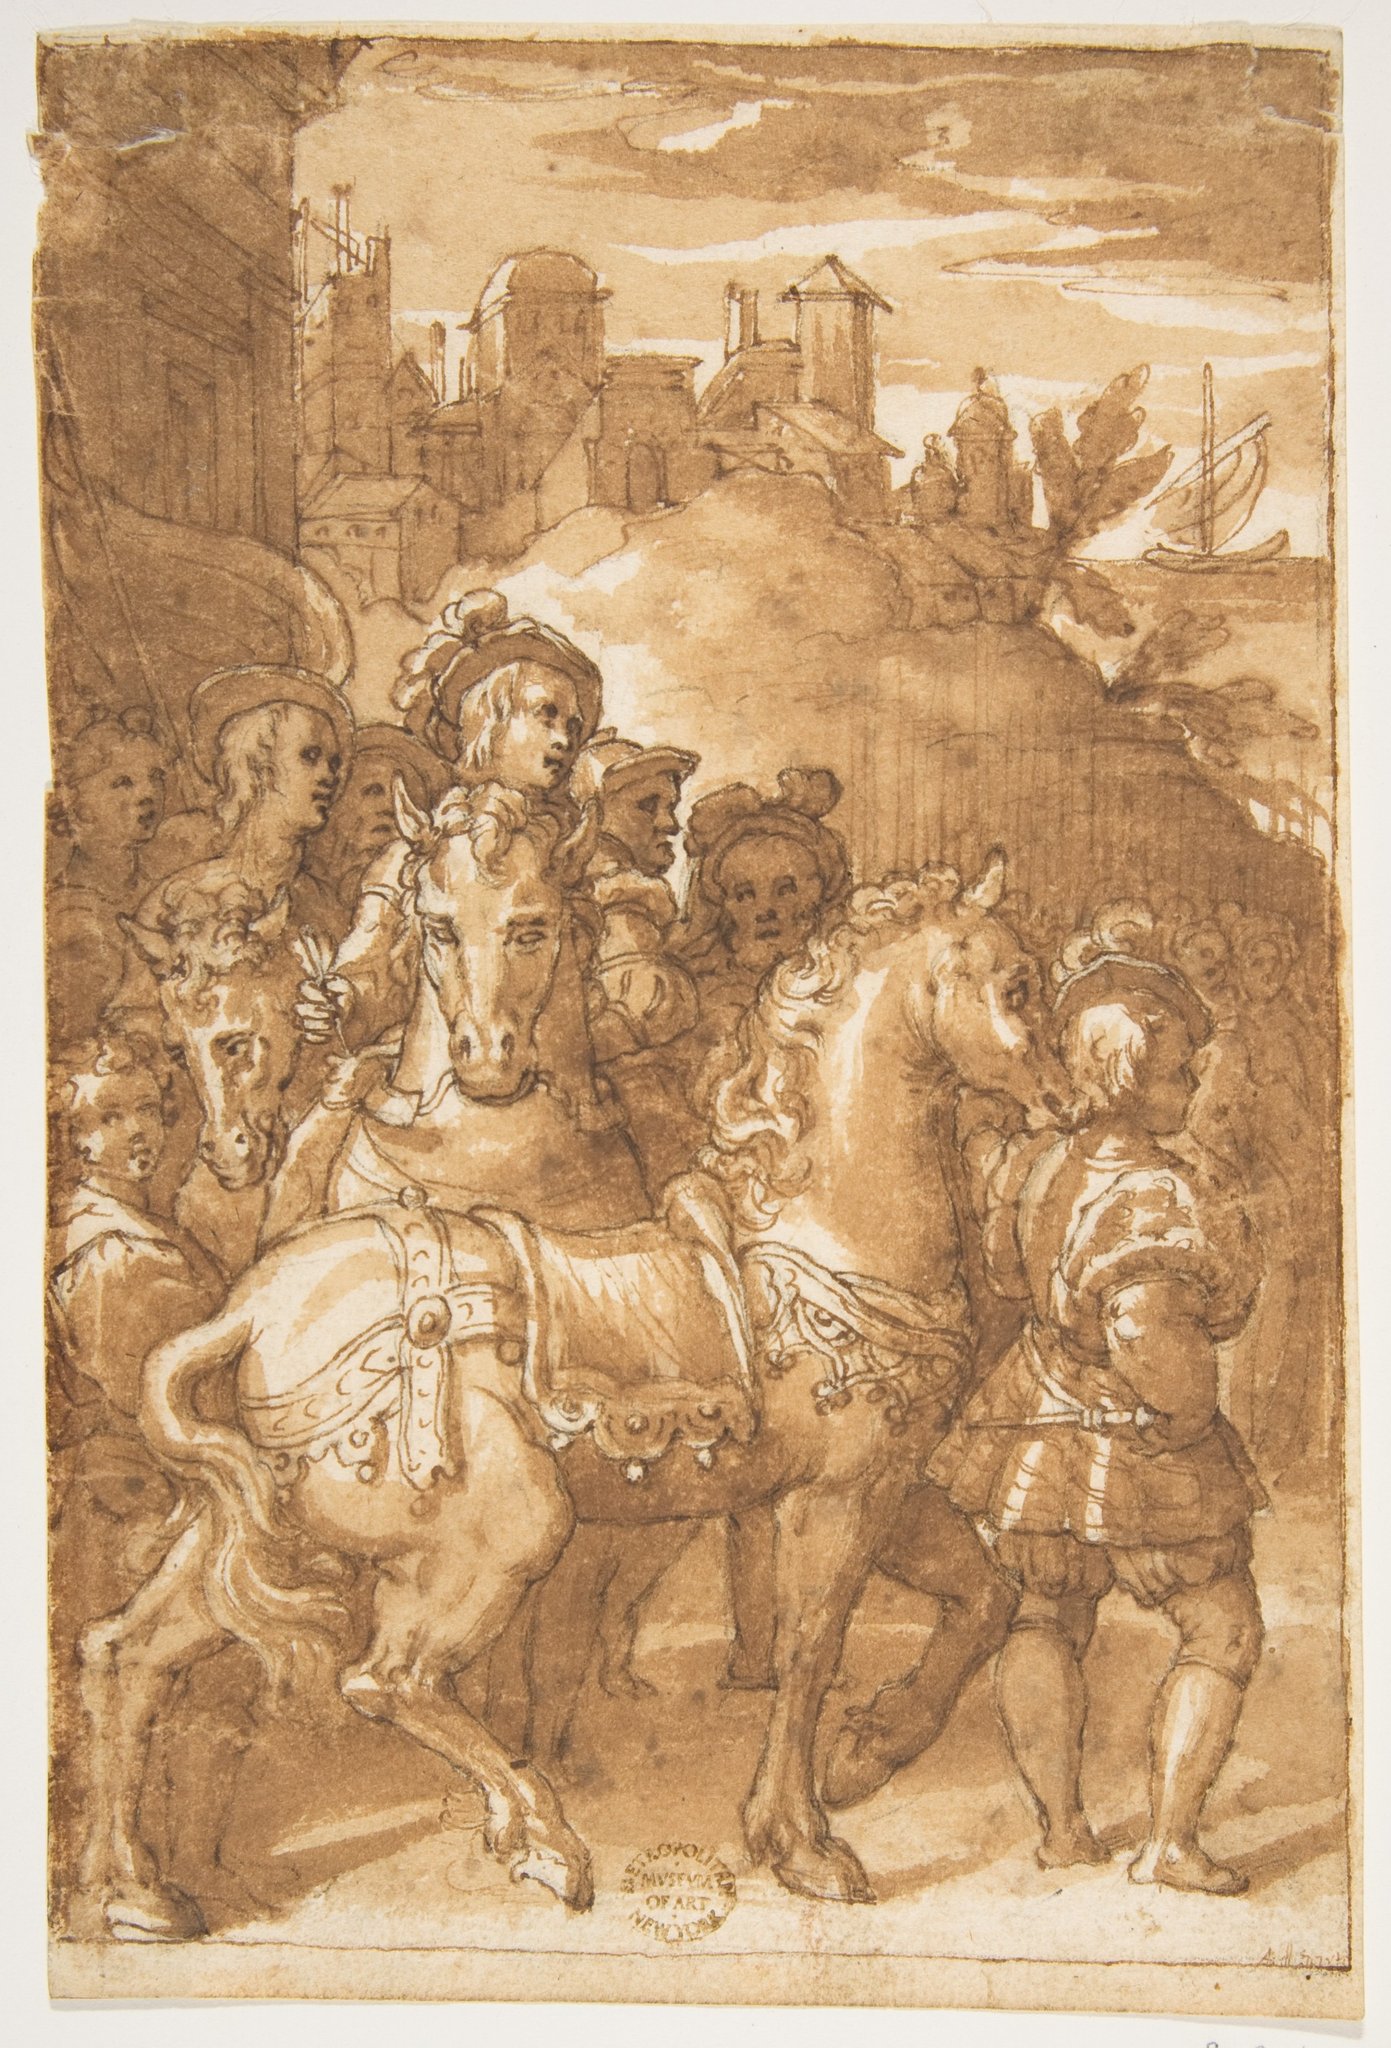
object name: drawing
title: Study for the Armistice between King Francis I of France and Emperor Charles V, fresco in the Palazzo Farnese, Caprarola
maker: taddeo zuccaro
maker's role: artist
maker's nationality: italian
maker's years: 1529-1566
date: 1501-1600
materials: chalk, ink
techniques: brush, pen, wash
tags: men,horses